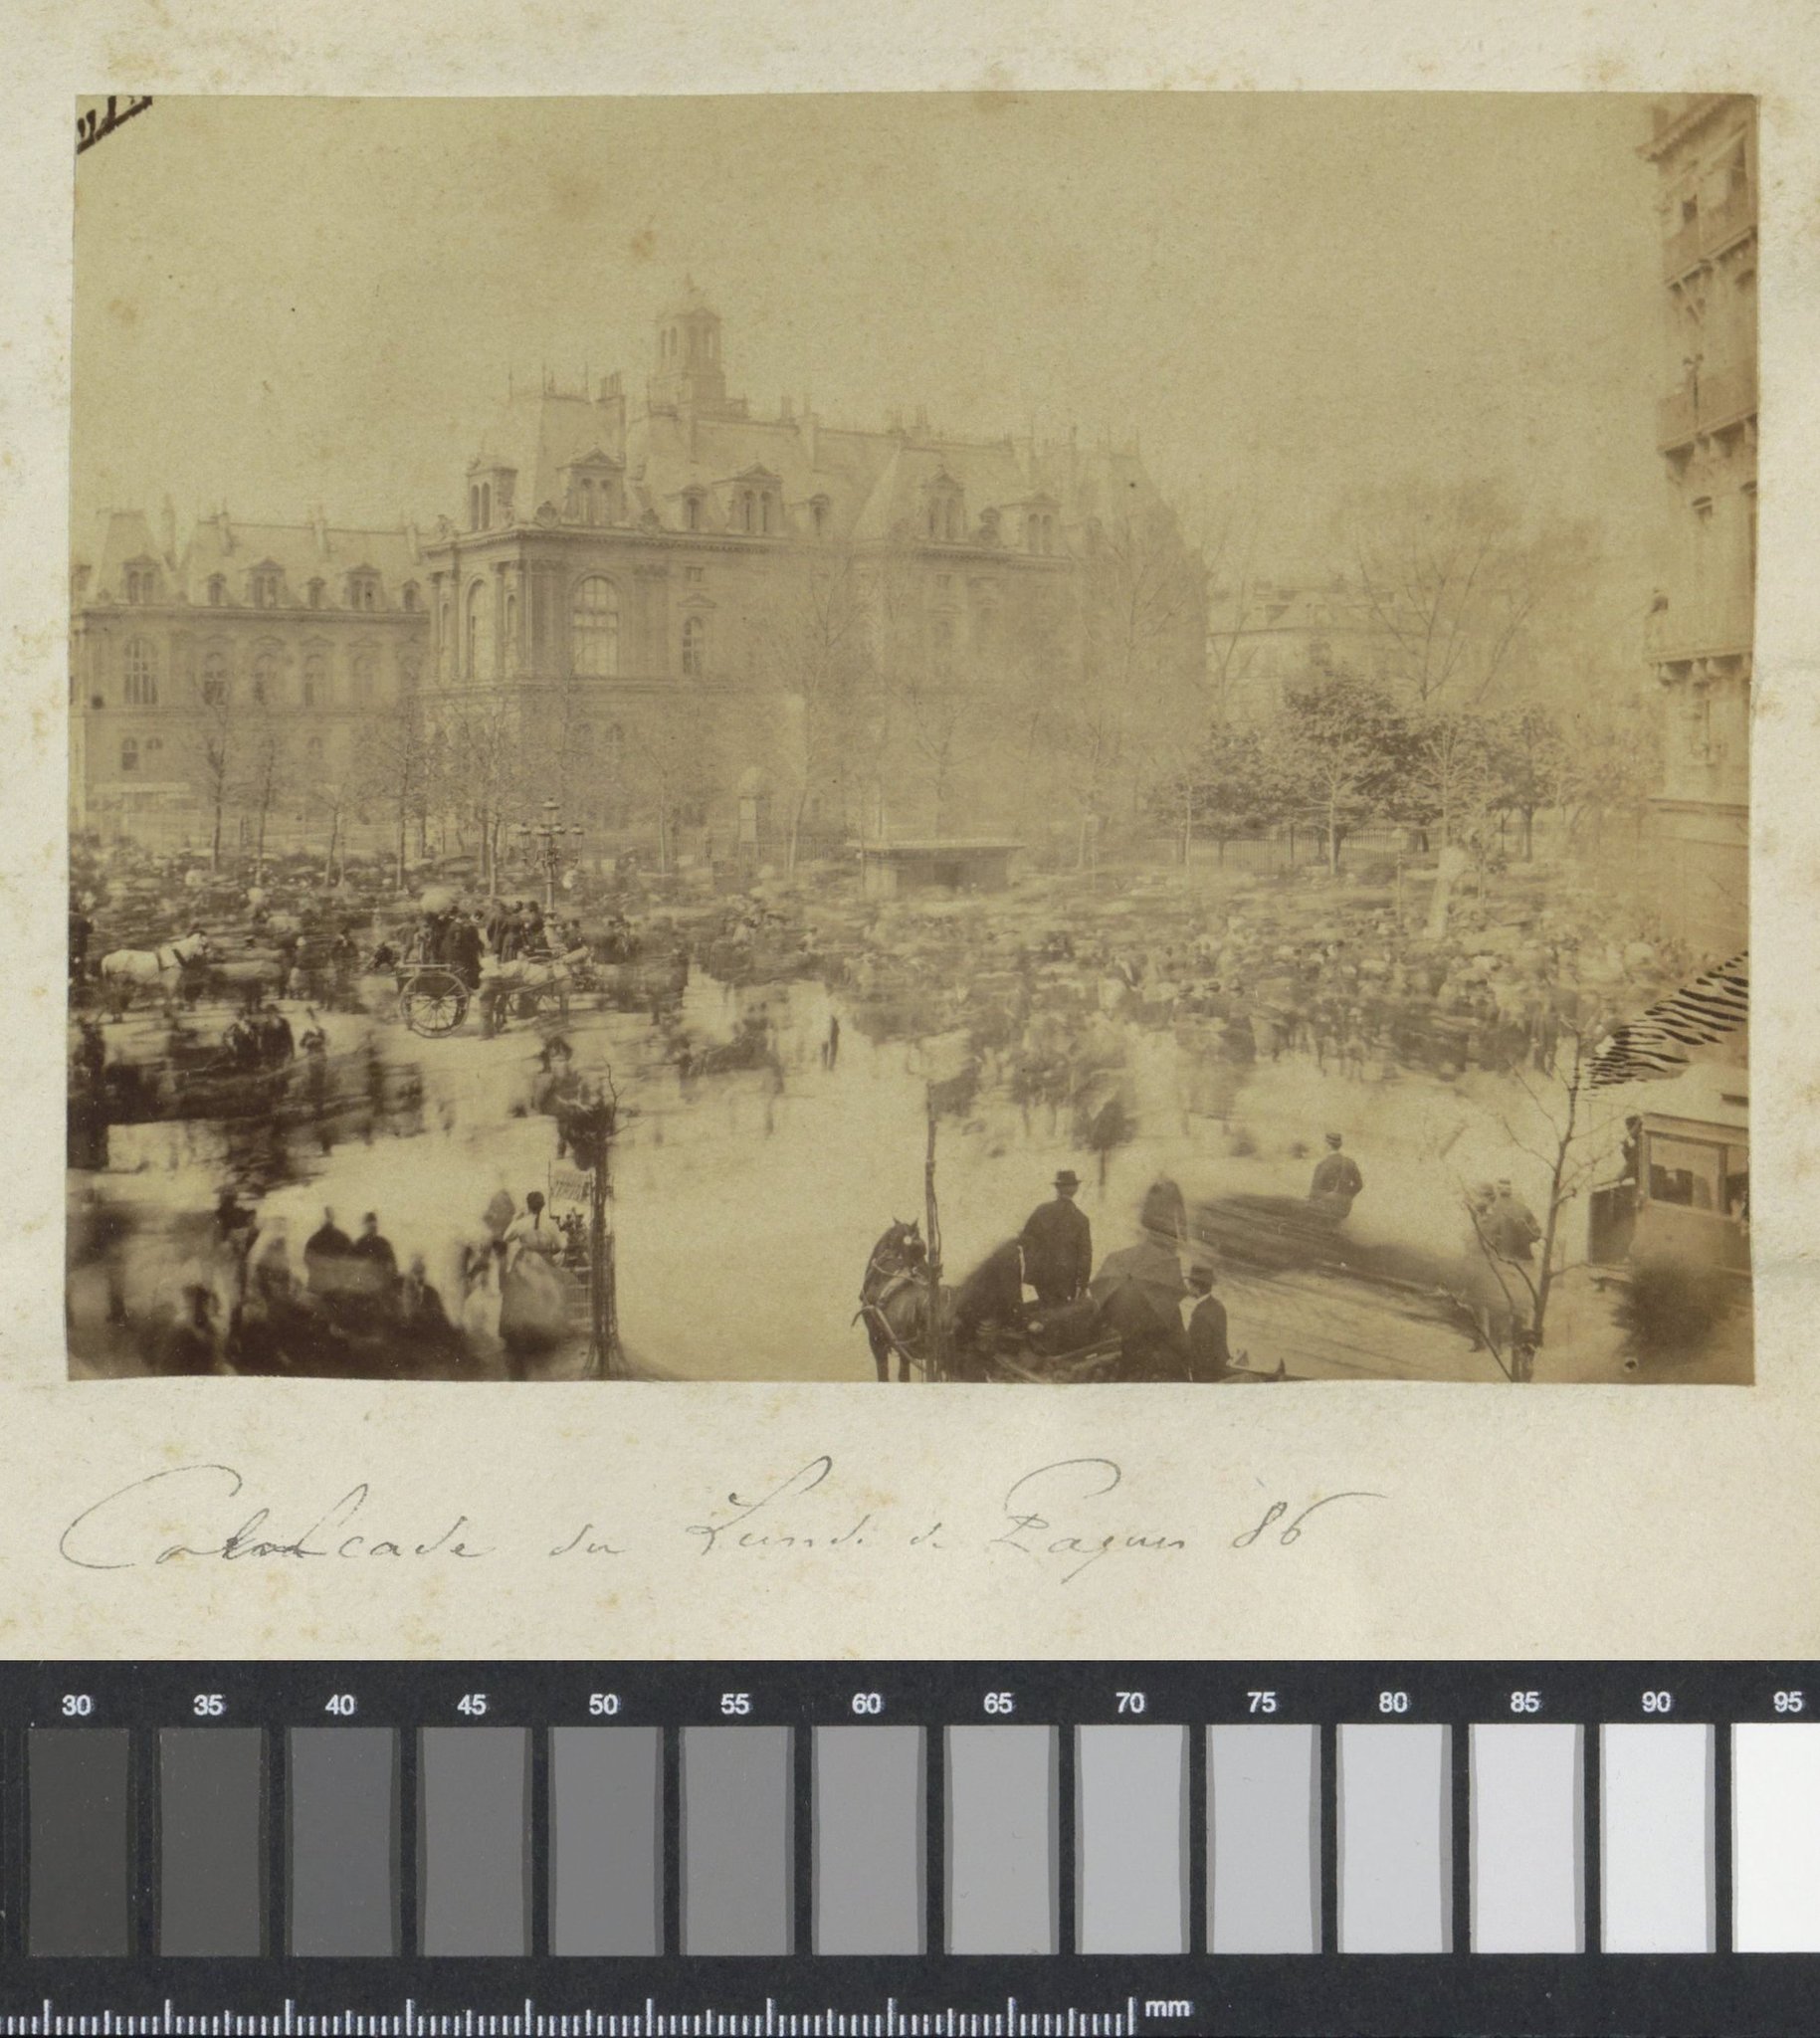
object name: photograph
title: Optocht bij het stadhuis van Le Havre ter gelegenheid van Paasmaandag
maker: Anonymous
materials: photographic support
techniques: albumen print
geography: le havre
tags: easter (non-liturgical celebration) (+ parade, pageant, cavalcade ~ festive activities), townhall, le havre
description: Onderdeel van Album van een Franse amateurfotograaf met opnames van familie, militairen, industrie, landschappen en bezienswaardigheden in Frankrijk.